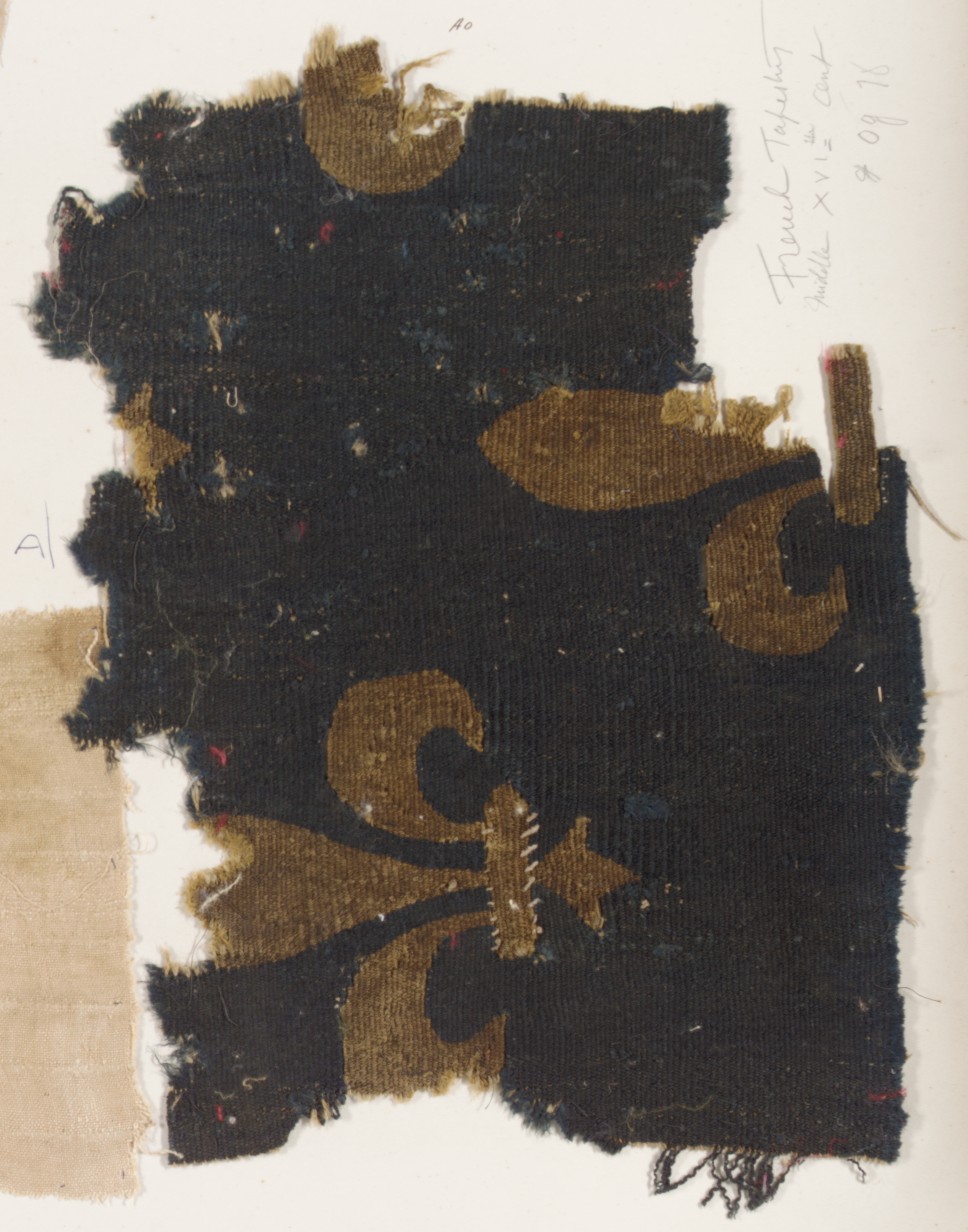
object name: tapestry fragment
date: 1501-1600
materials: wool